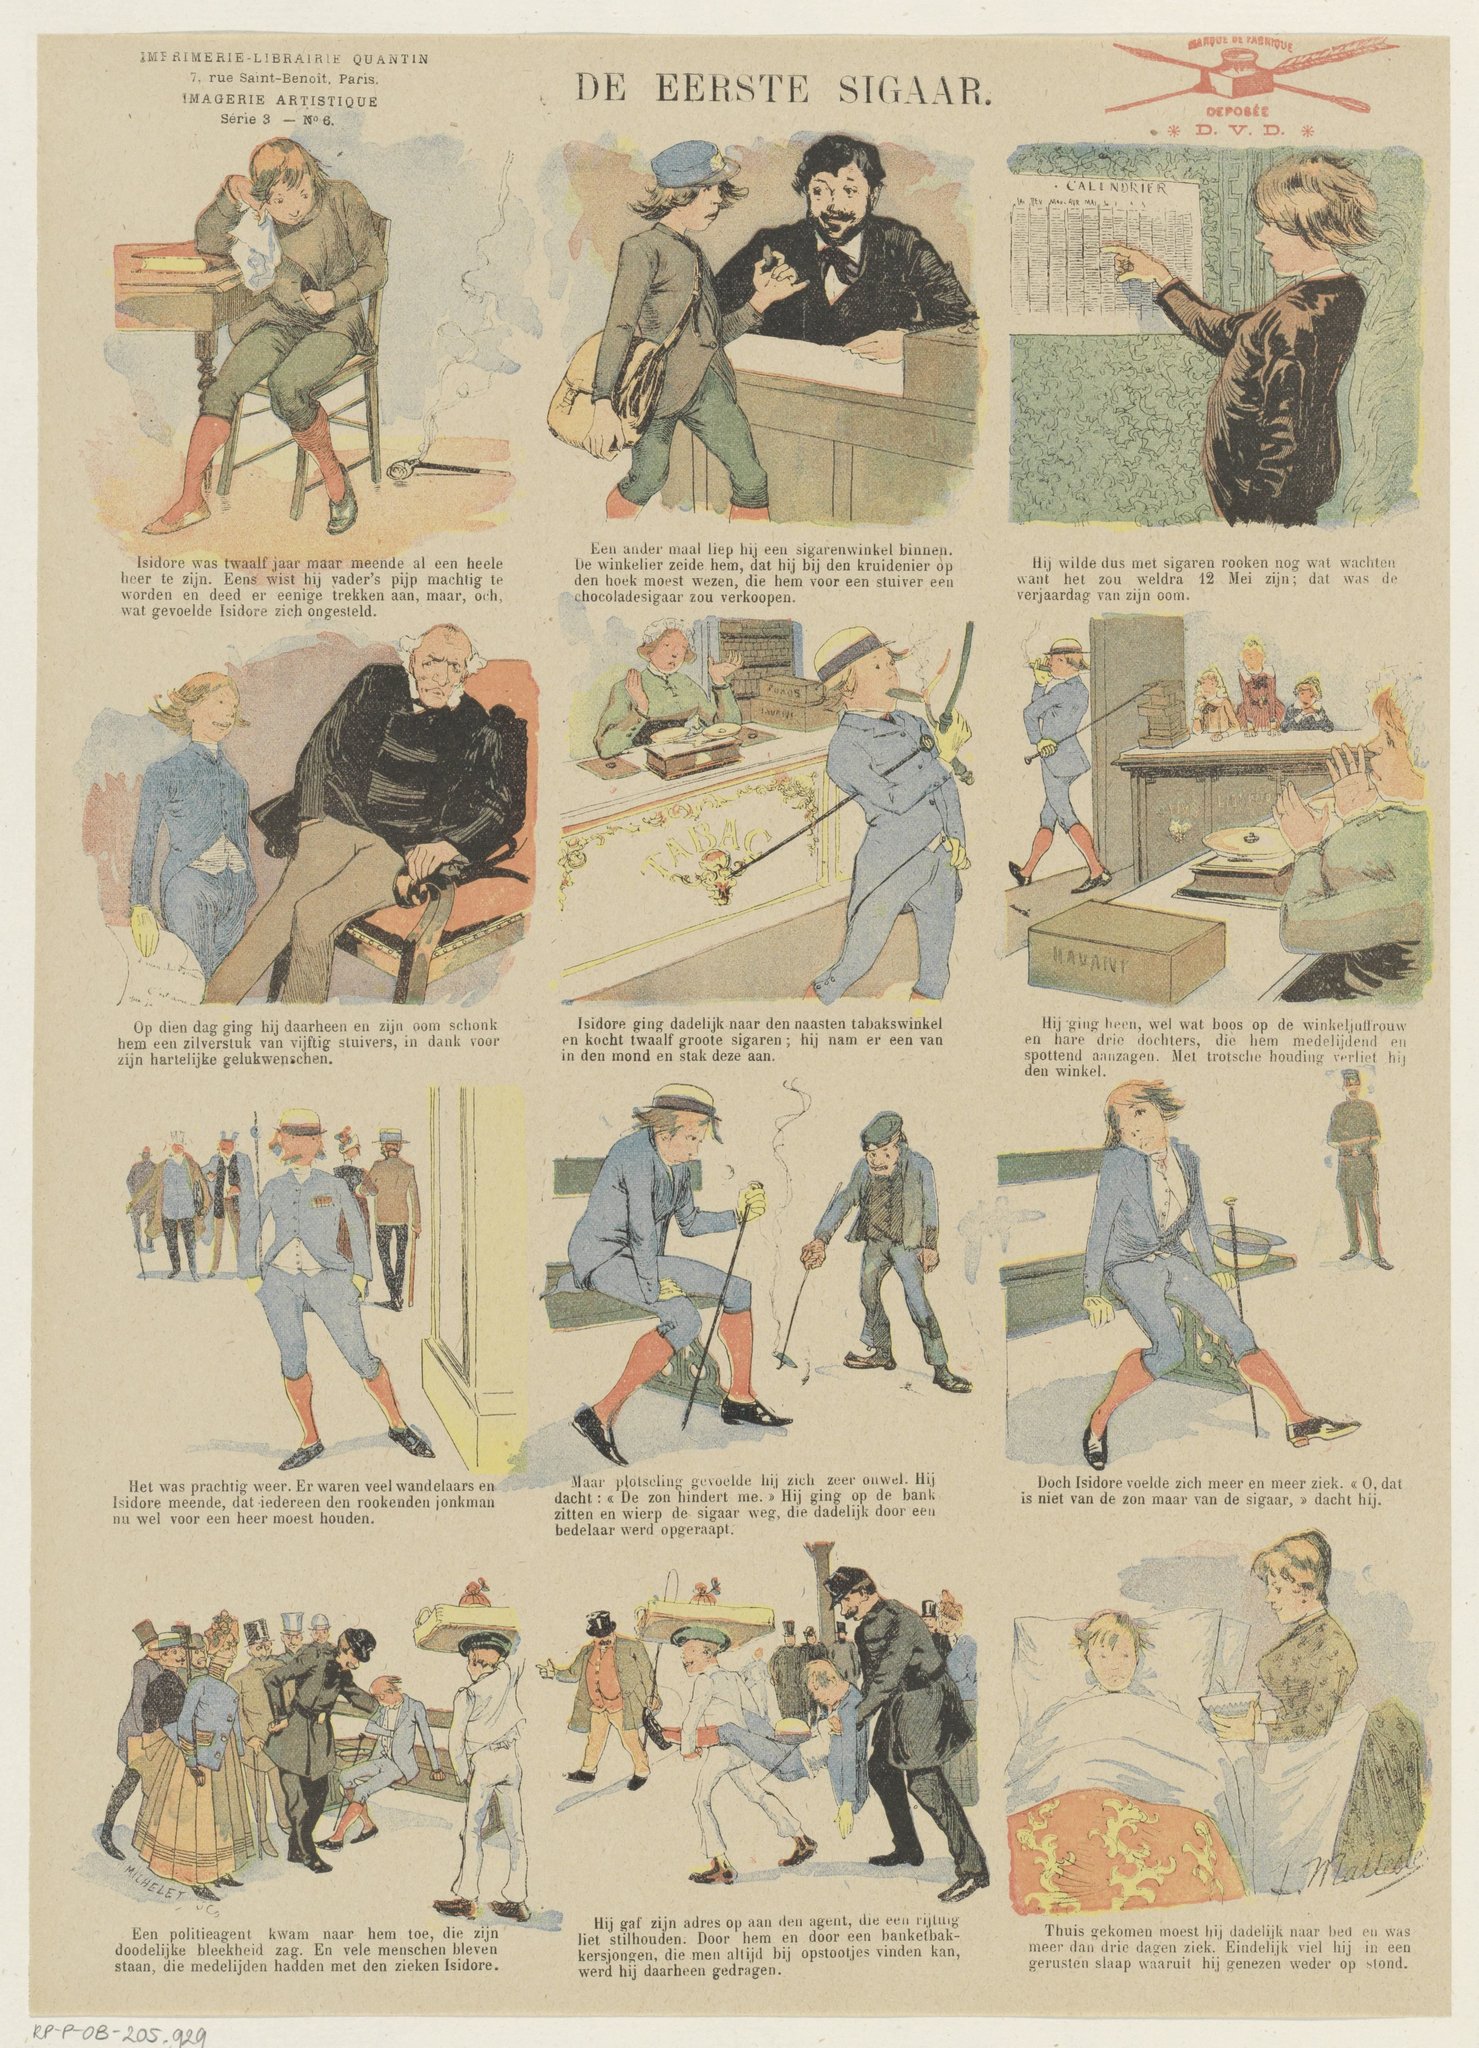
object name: print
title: De eerste sigaar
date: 1876-1890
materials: paper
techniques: lithograph, letterpress printing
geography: paris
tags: cigar, sick-bed, tales and fairy tales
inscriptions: : ‘marque de fabrique / deposée / * D.V.D. *’, collector's mark: Lugt 2760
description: Blad met 11 voorstellingen van de twaalfjarige Isidoor die ziek wordt van het roken van een sigaar. Onder elke voorstelling een onderschrift. Genummerd linksboven: Série 3. - No. 6.